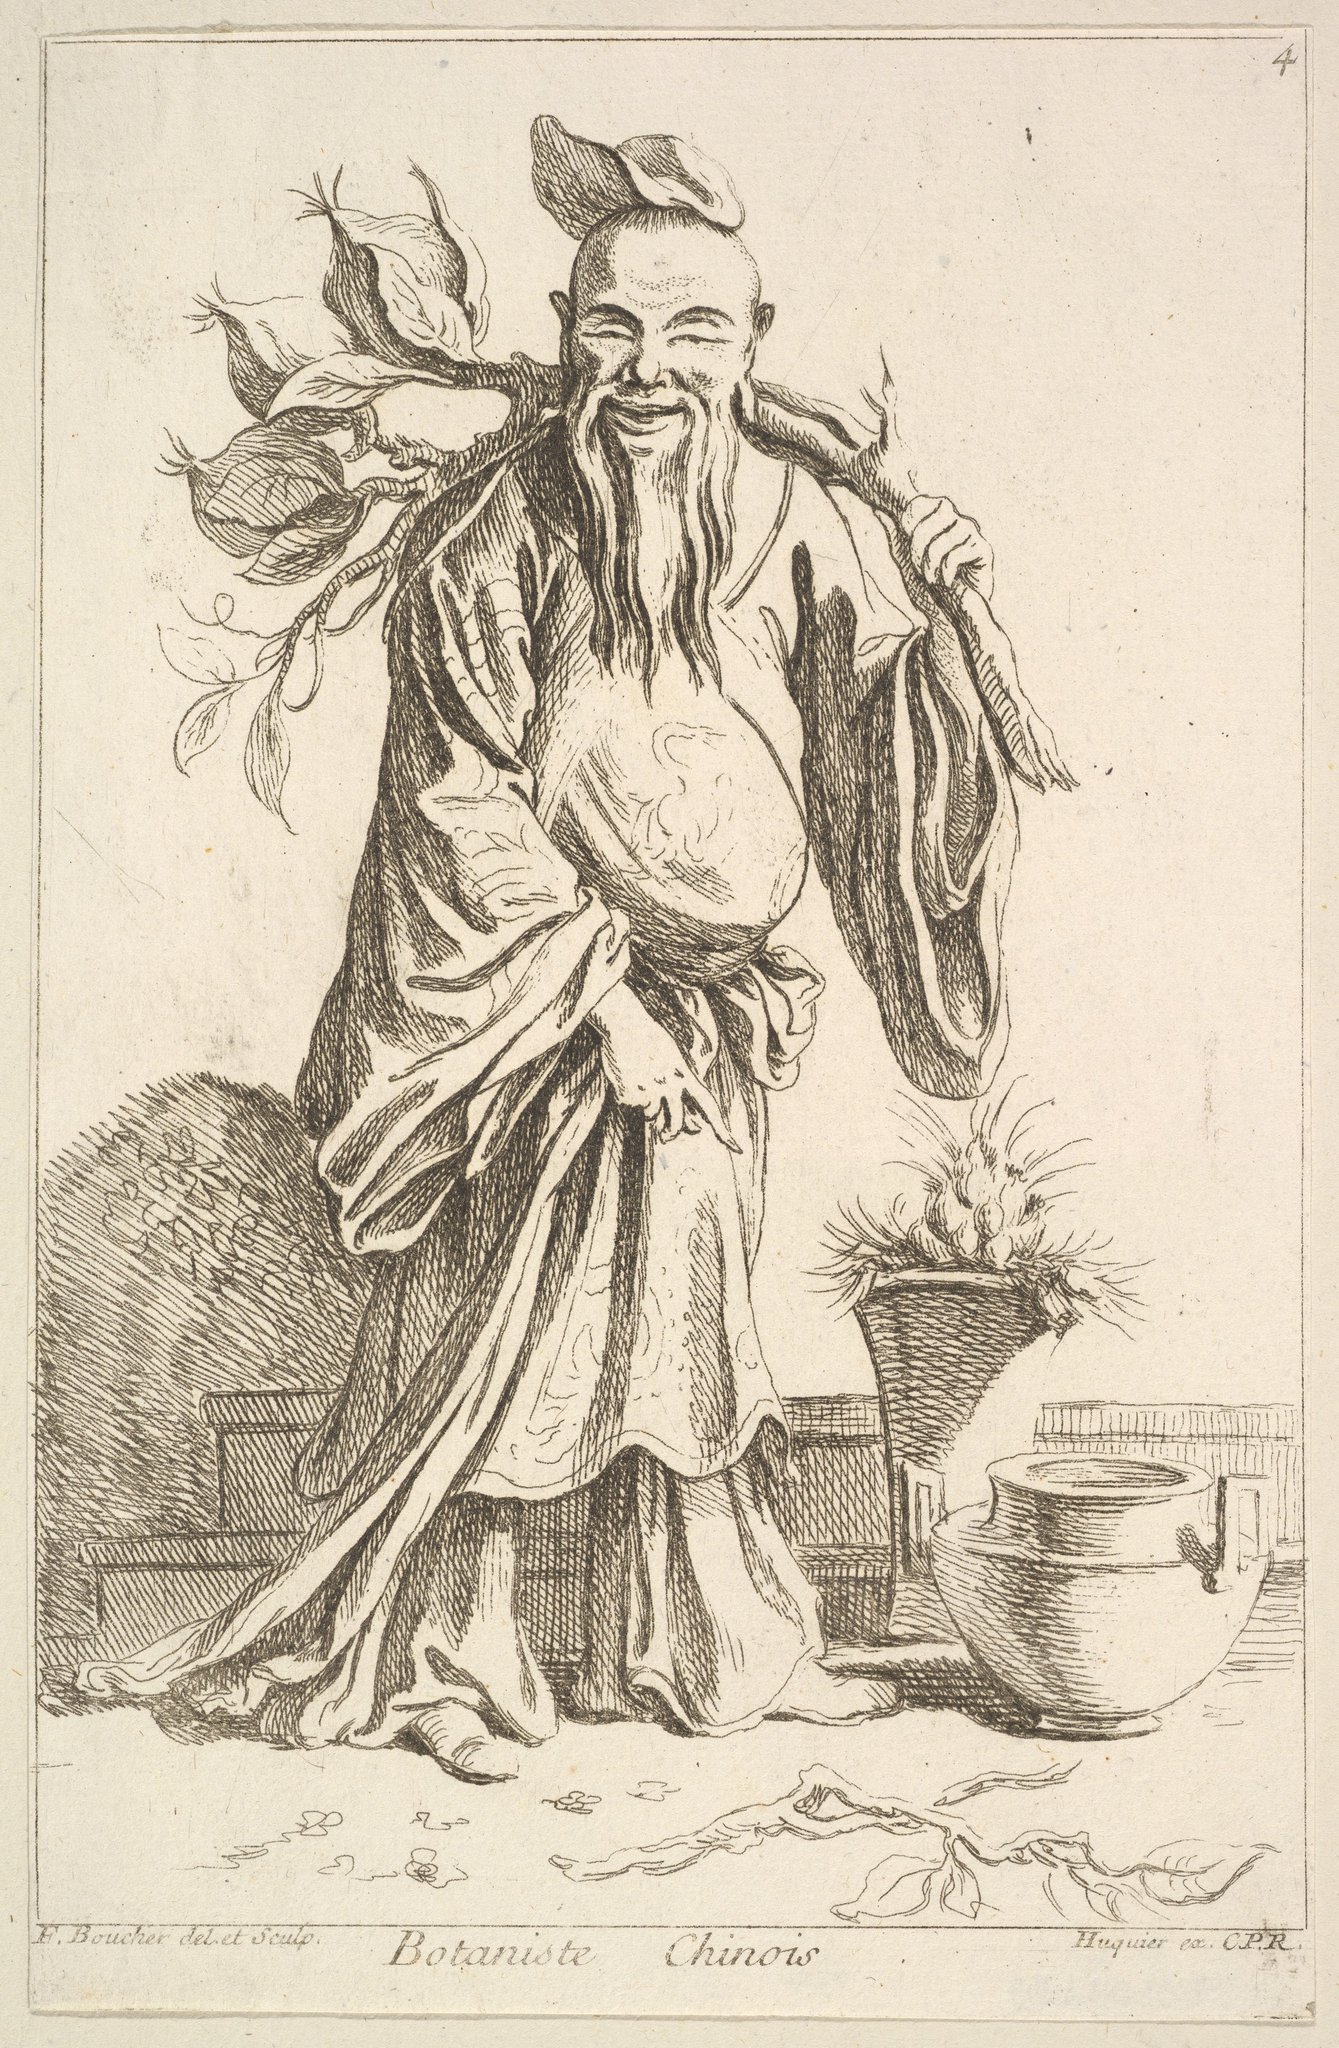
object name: print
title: Chinese botanist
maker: françois boucher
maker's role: artist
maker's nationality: french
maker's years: 1703-1770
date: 1738-1745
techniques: etching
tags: men,leaves